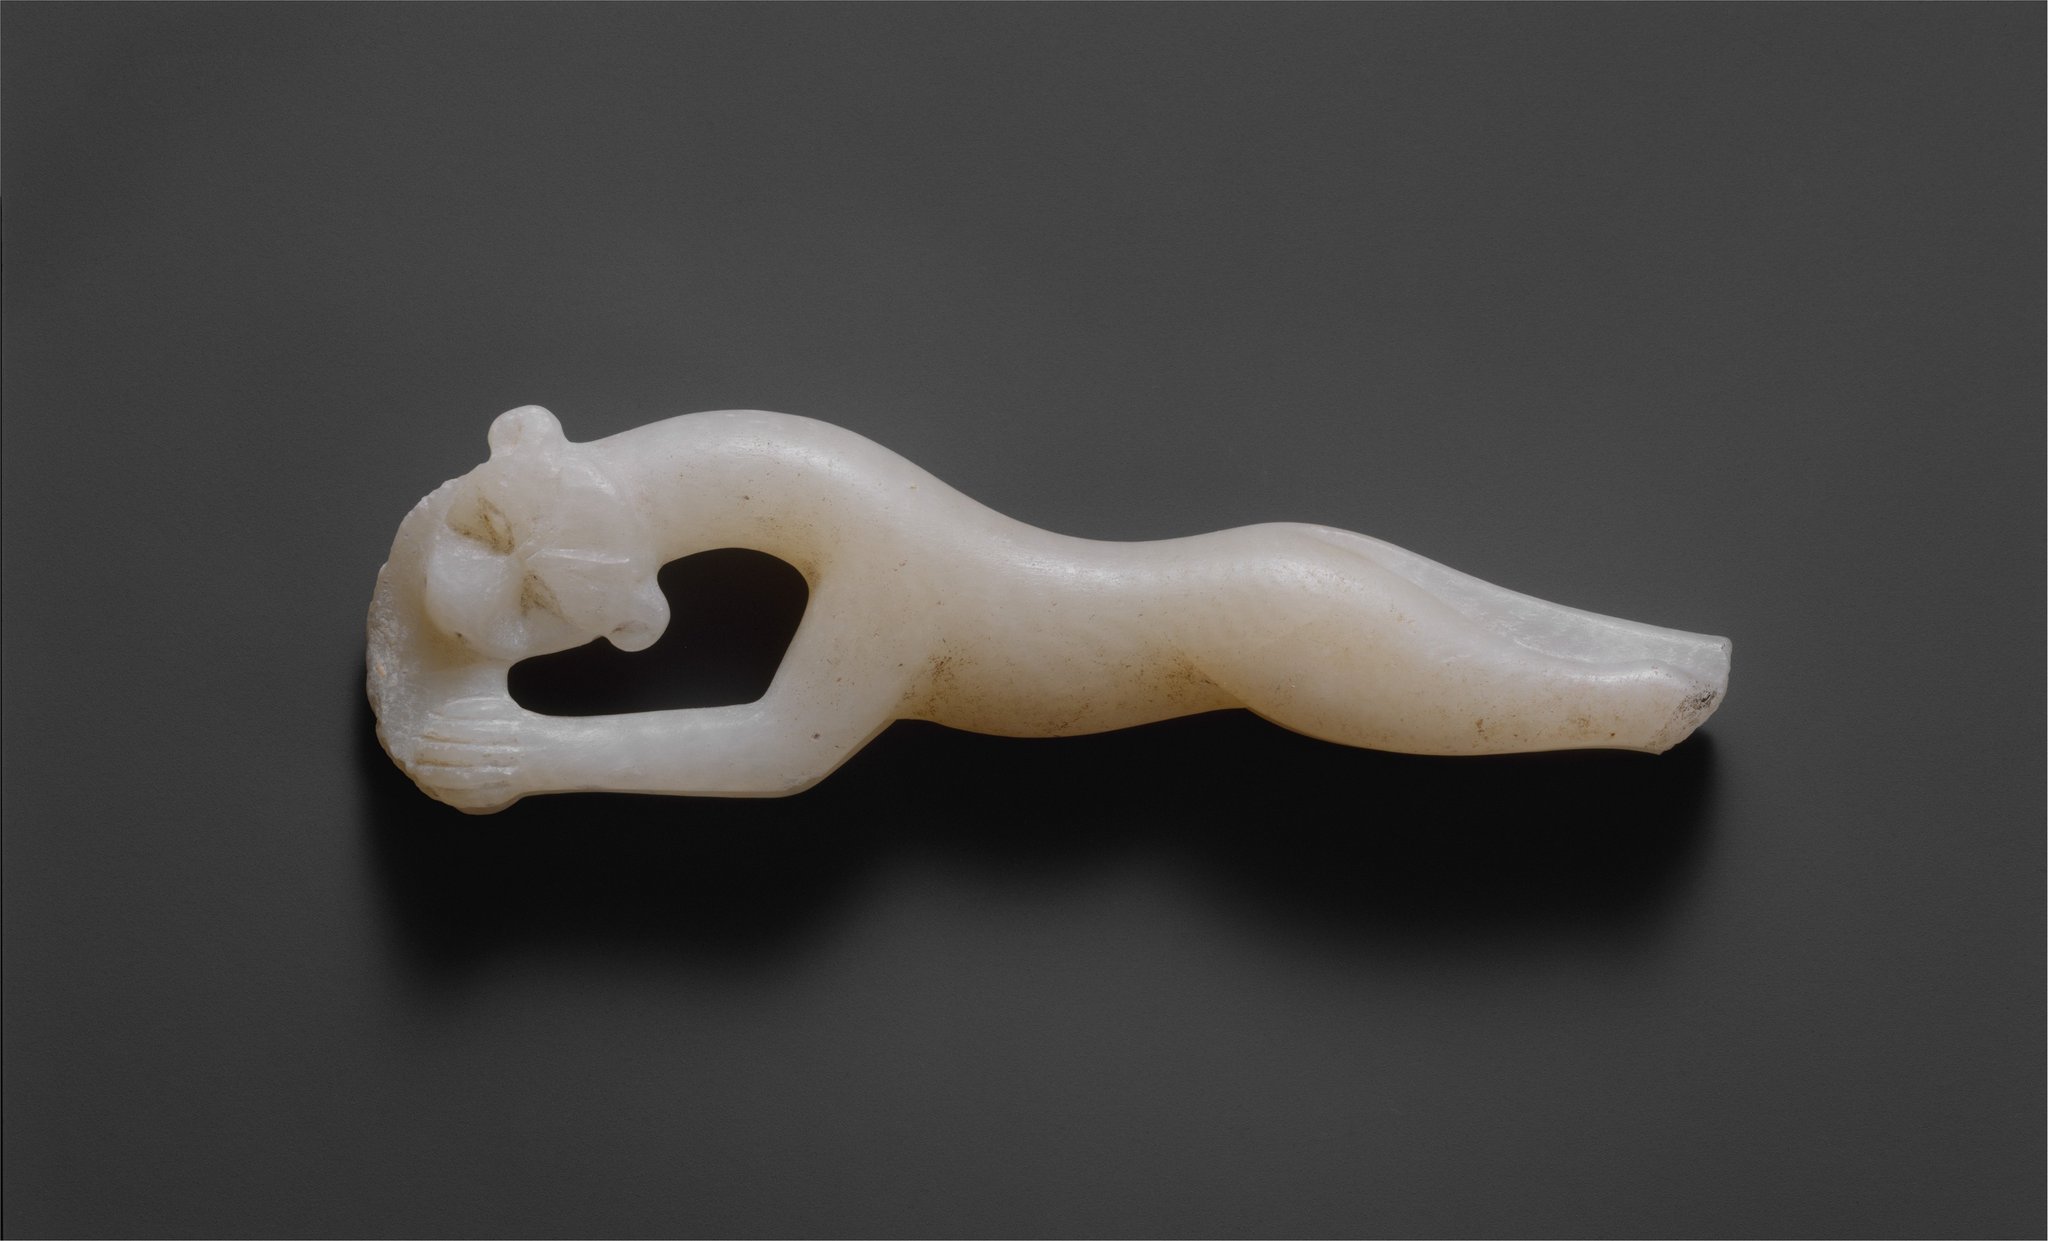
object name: cosmetic spoon, handle, feline, leopard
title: Handle of a Cosmetic Spoon in the Form of a Leopard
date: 1390-1352 BCE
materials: stone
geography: egypt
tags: leopards